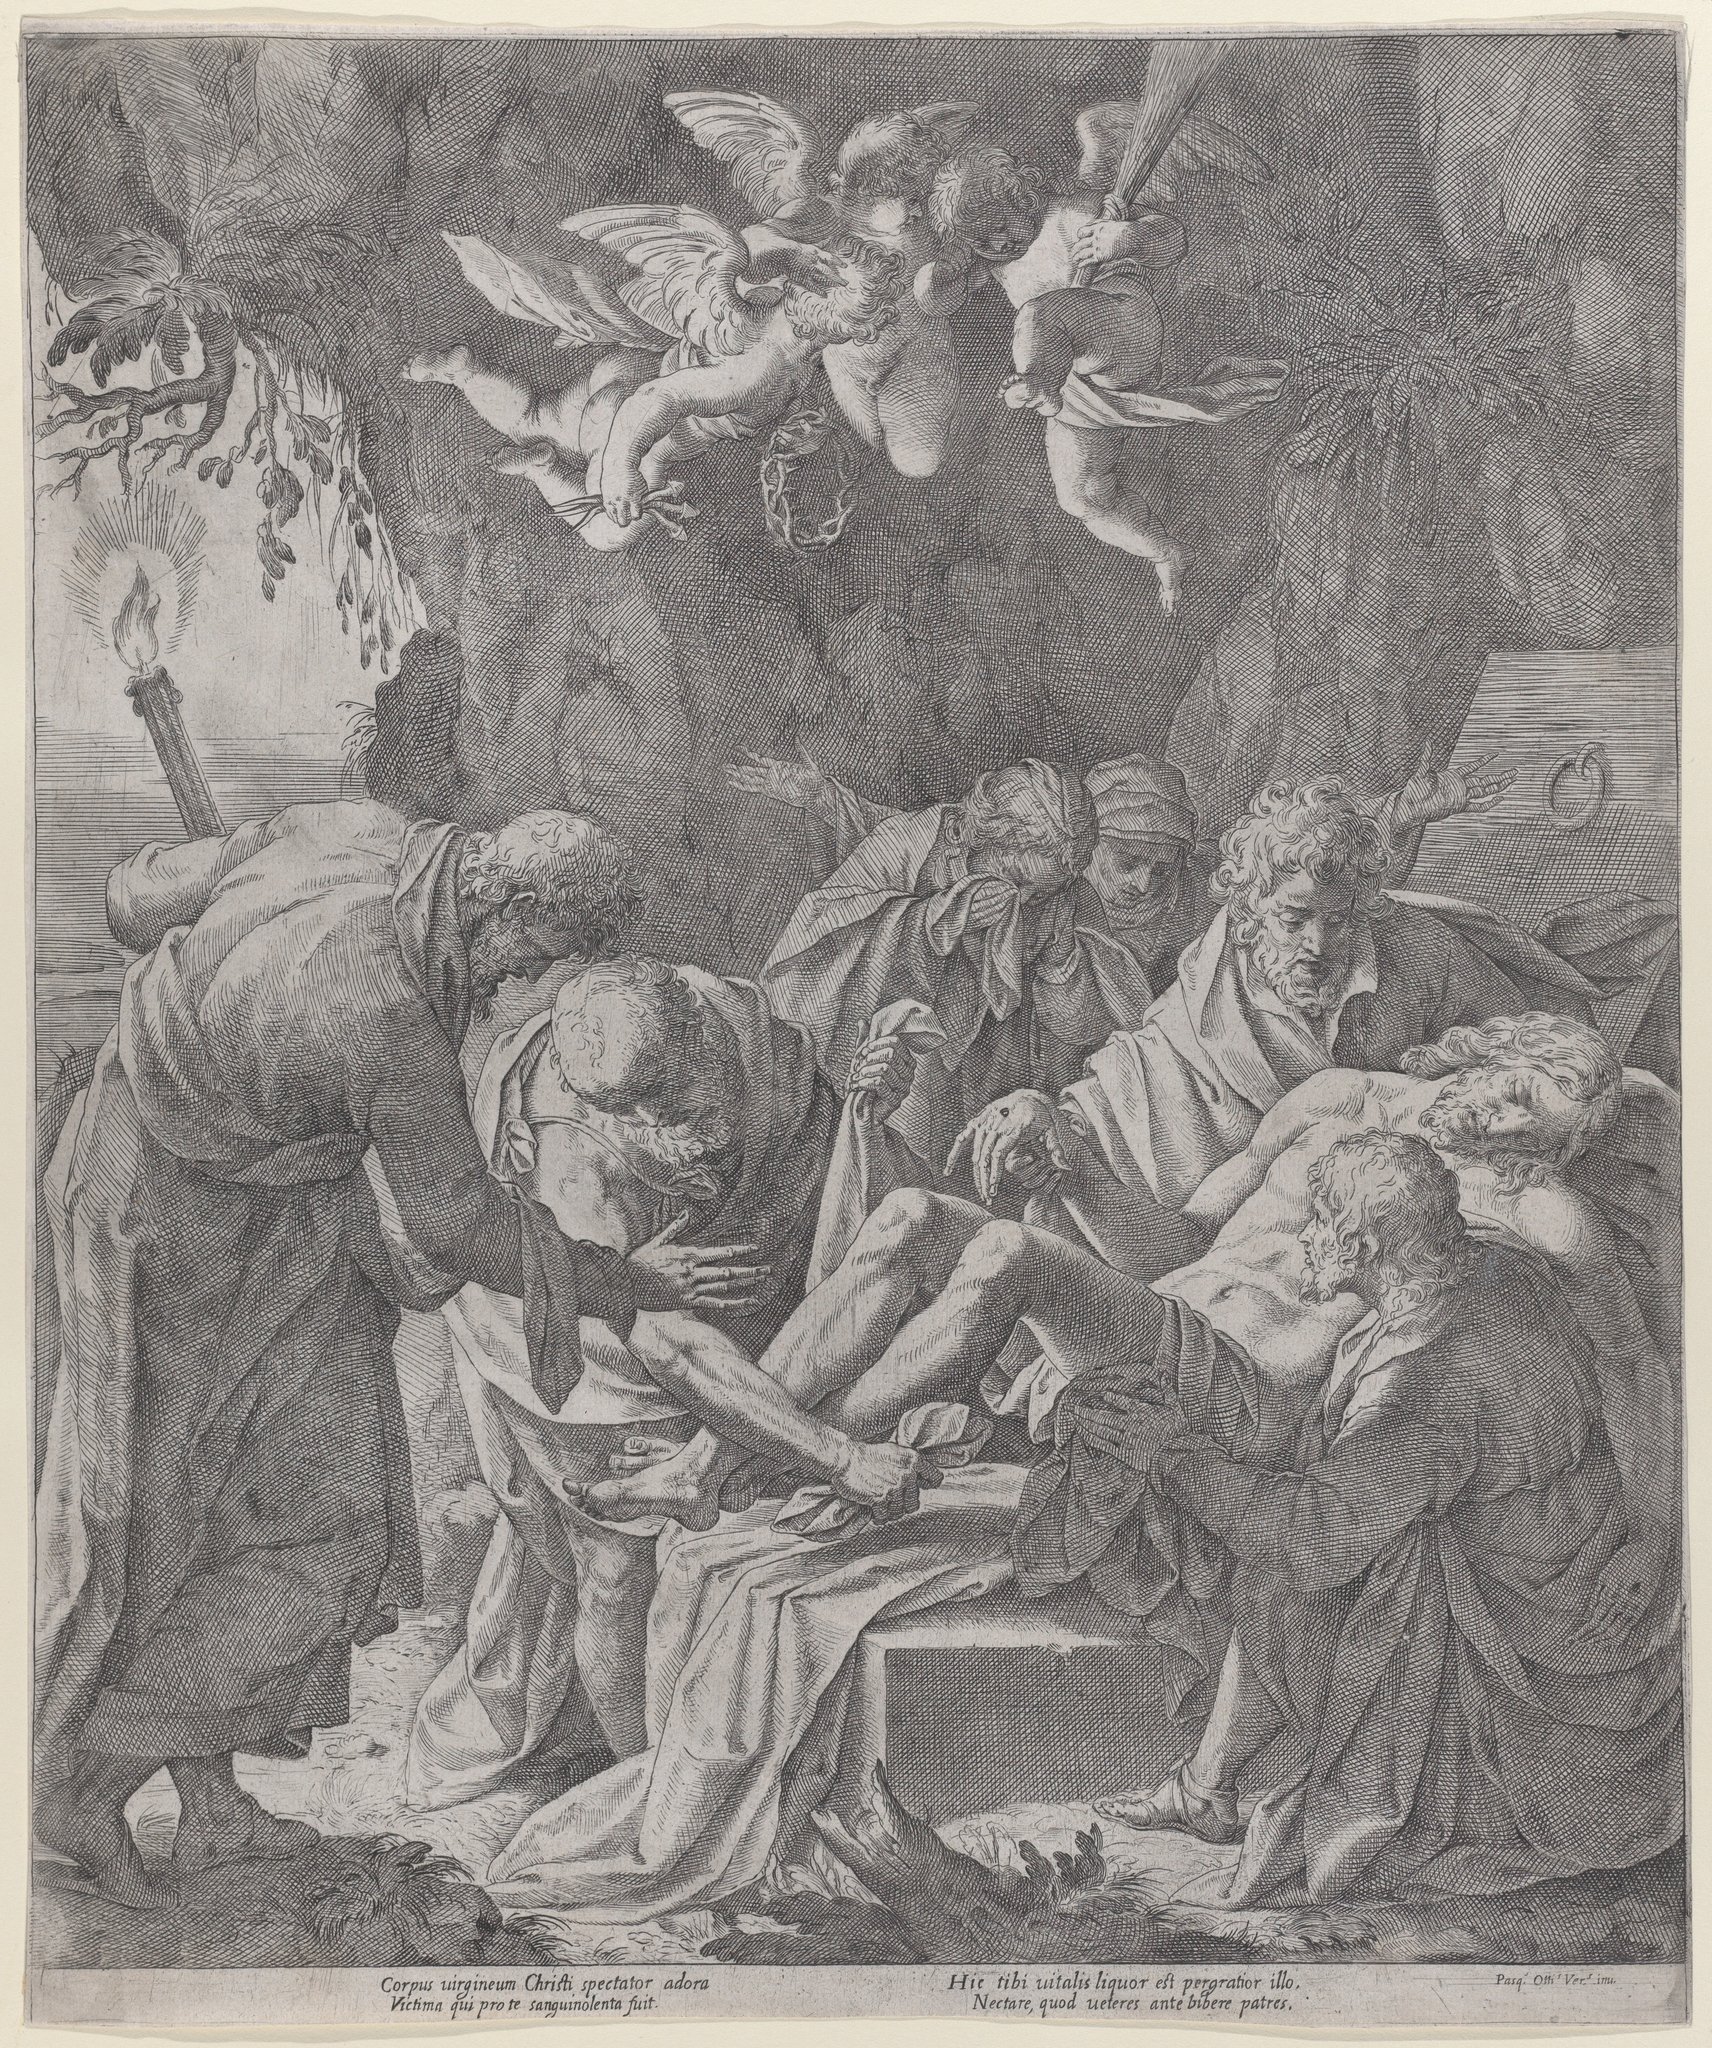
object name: print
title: Christ being laid into the sepulcher as the Virgin stands weeping behind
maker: pasquale ottino (pasqualotto)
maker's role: artist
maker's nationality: italian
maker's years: 1578-1630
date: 1600-1630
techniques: etching